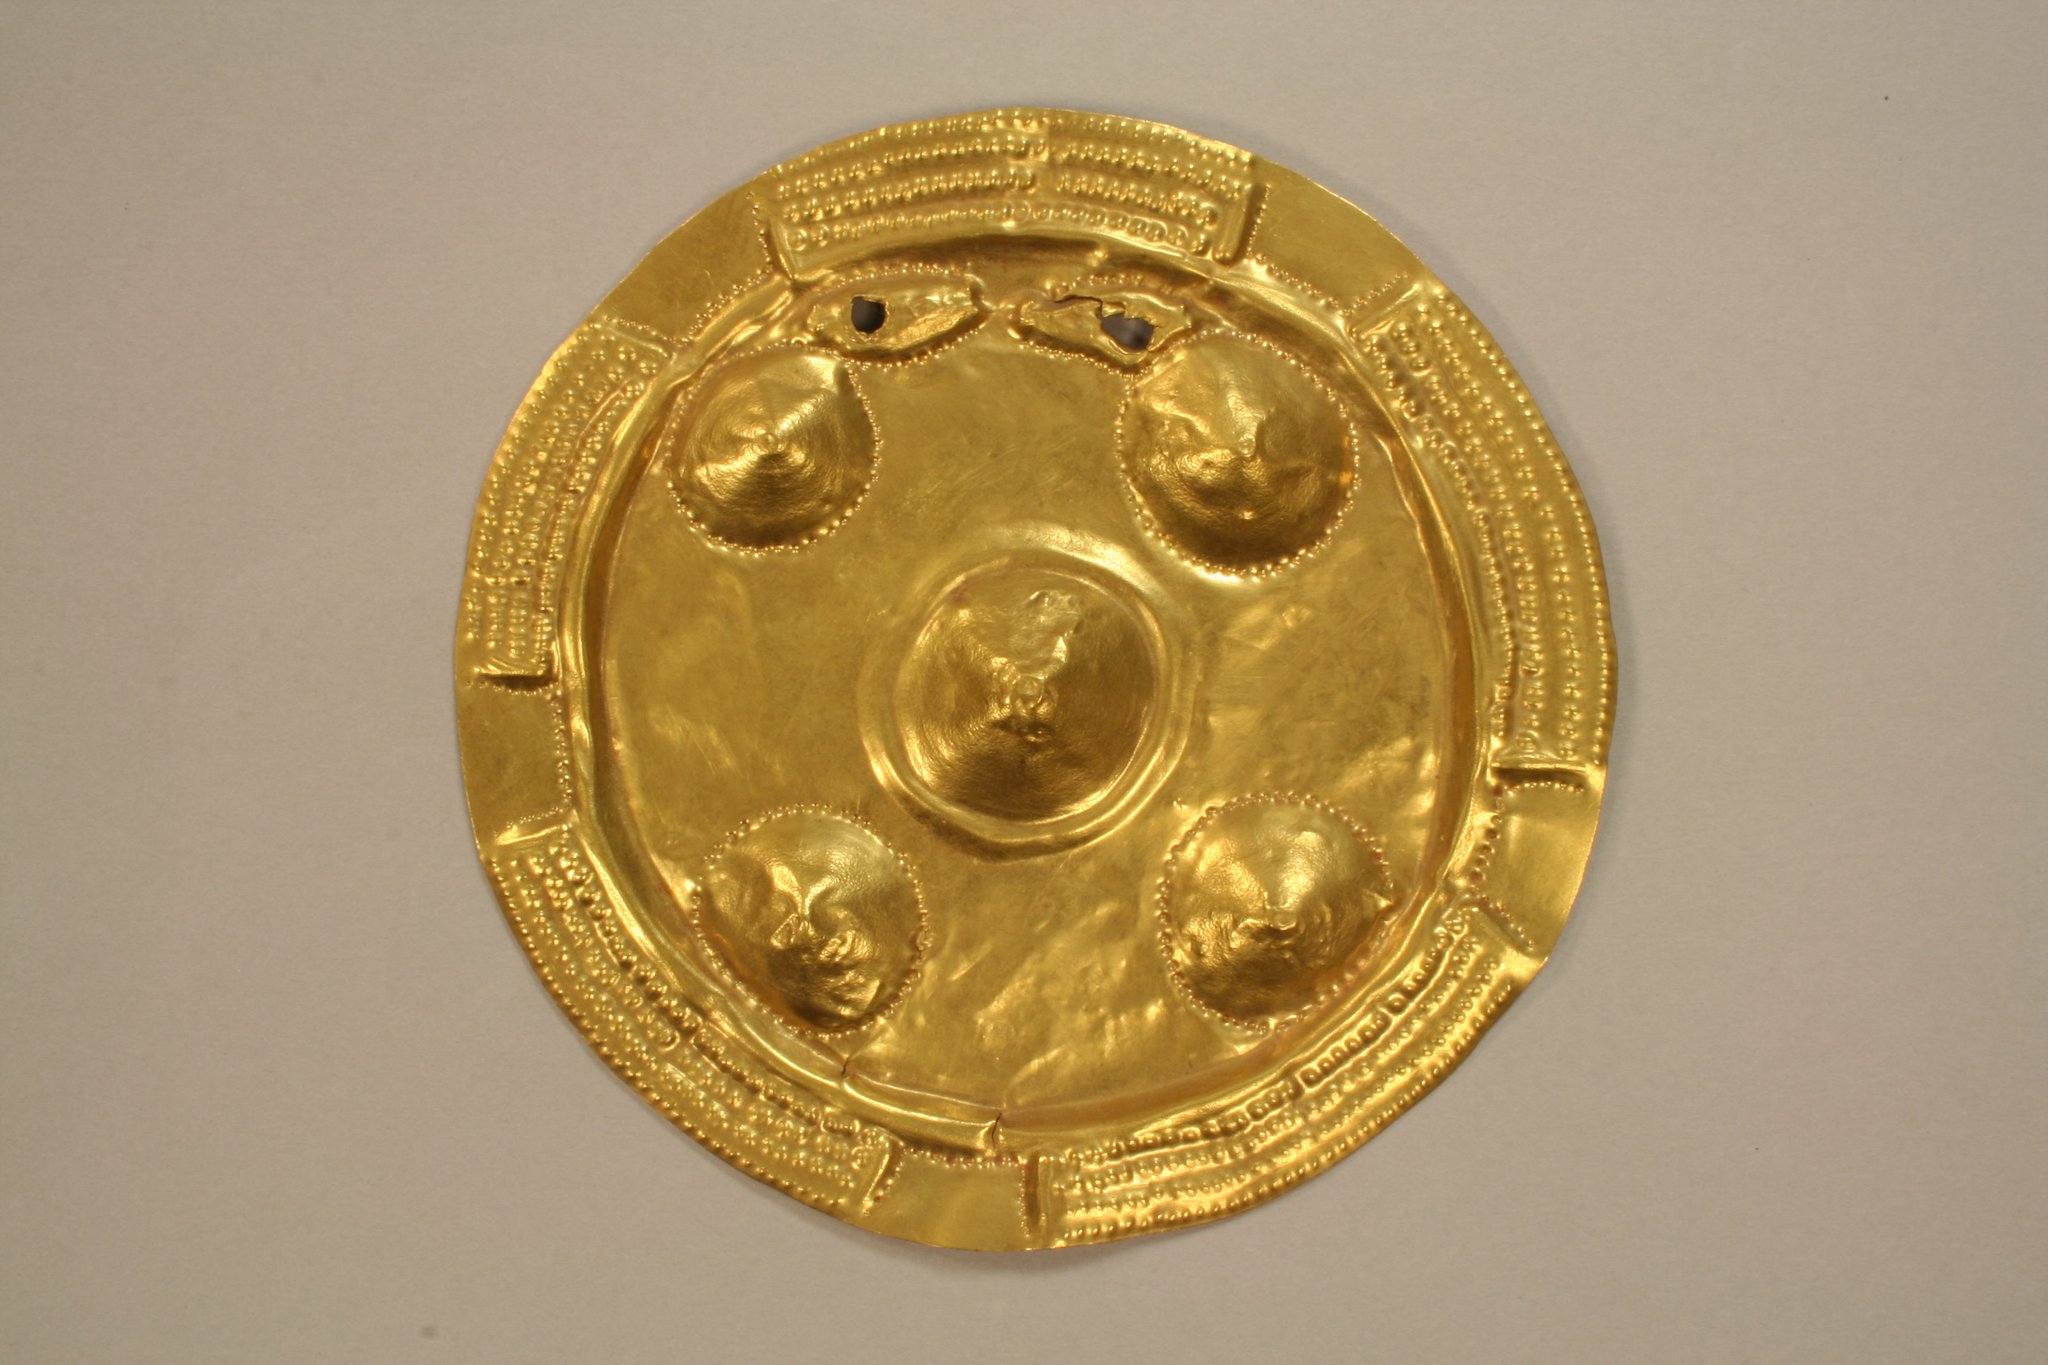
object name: disk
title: Hammered Gold Disk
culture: veraguas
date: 1001-1600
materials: gold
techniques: hammering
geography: panama